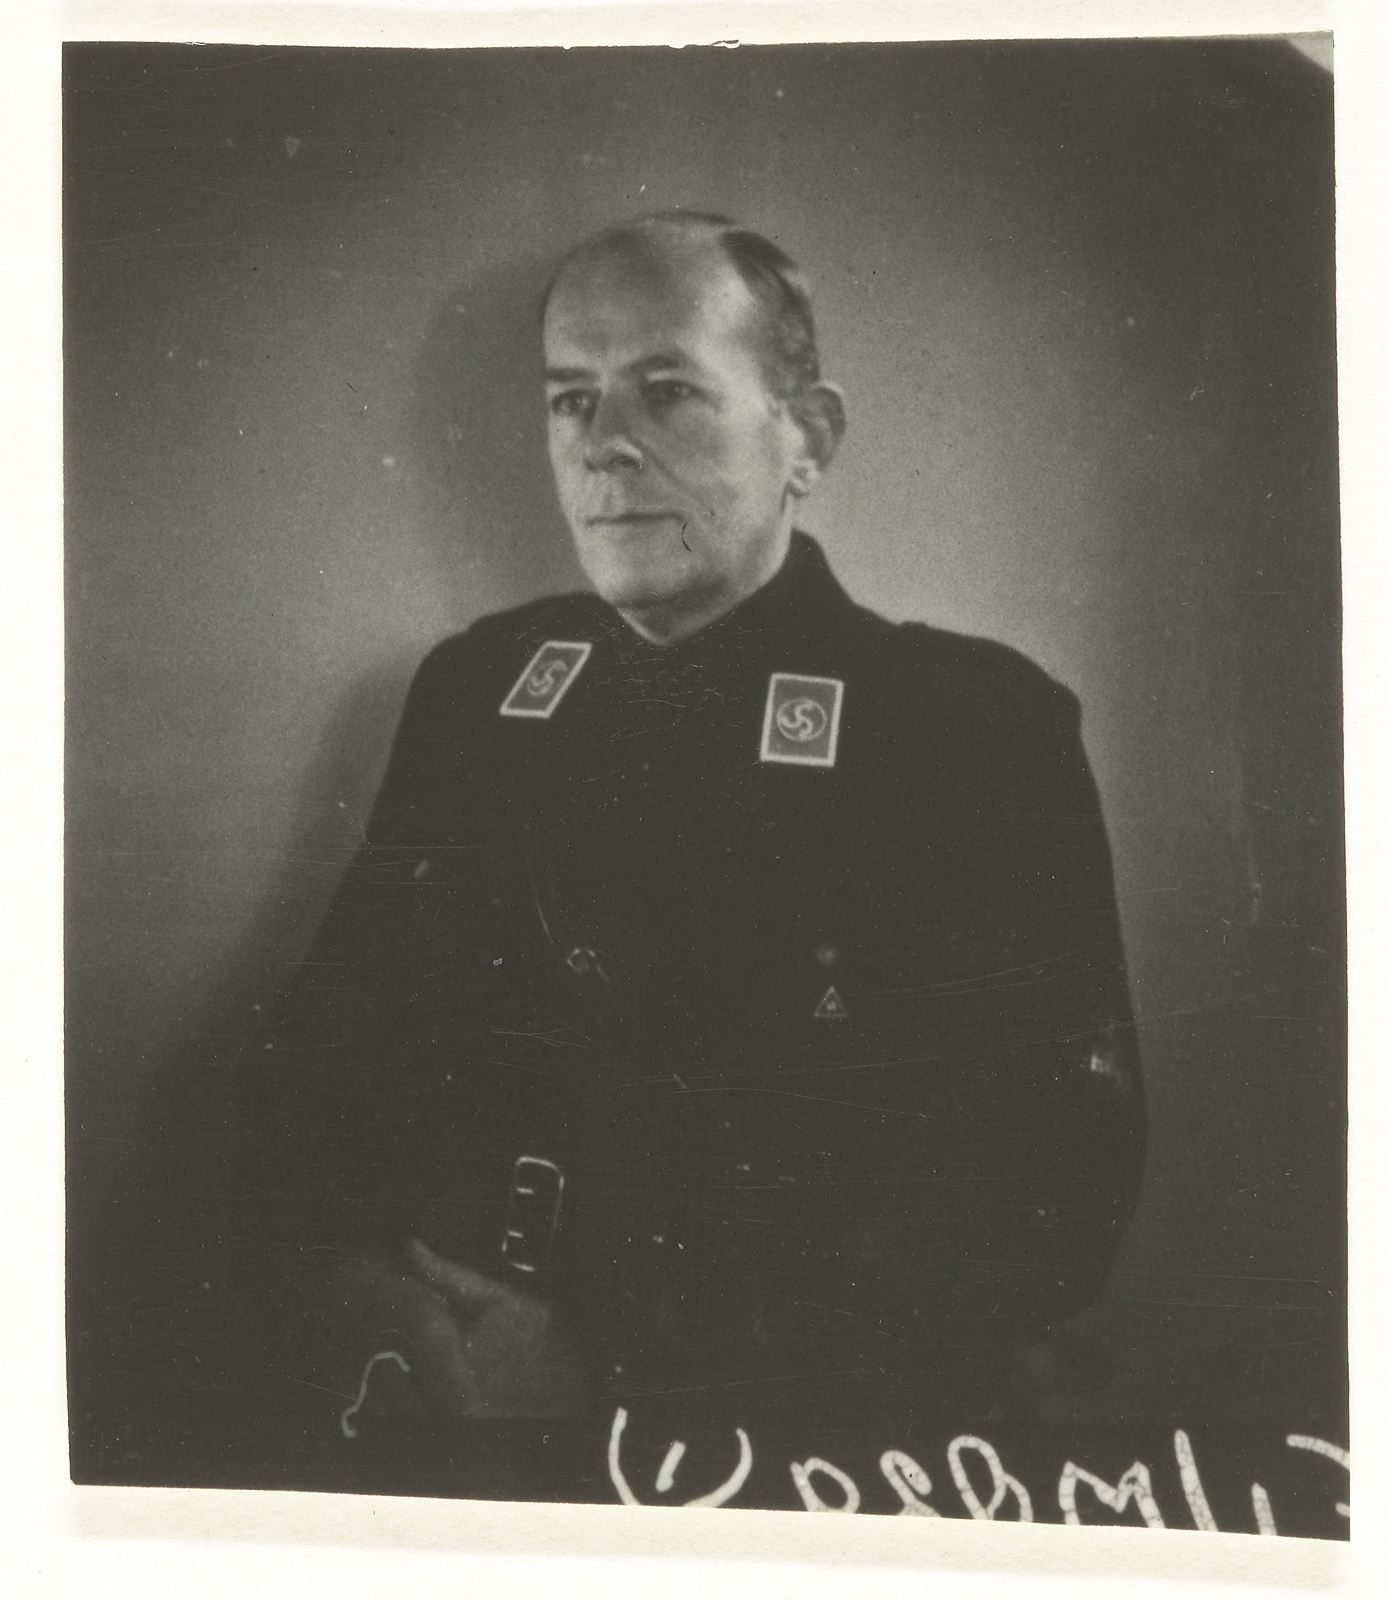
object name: contact print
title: Portret van een lid van de NSB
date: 1940-1944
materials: photographic support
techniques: photography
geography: netherlands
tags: anonymous historical person portrayed, netherlands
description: Portret van een lid van de NSB. Op zijn kraag een distinctief met het wentelend zonnerad, mogelijk gaat het om een plaatsvervangend sectieleider van een der Gilden of Fronten.